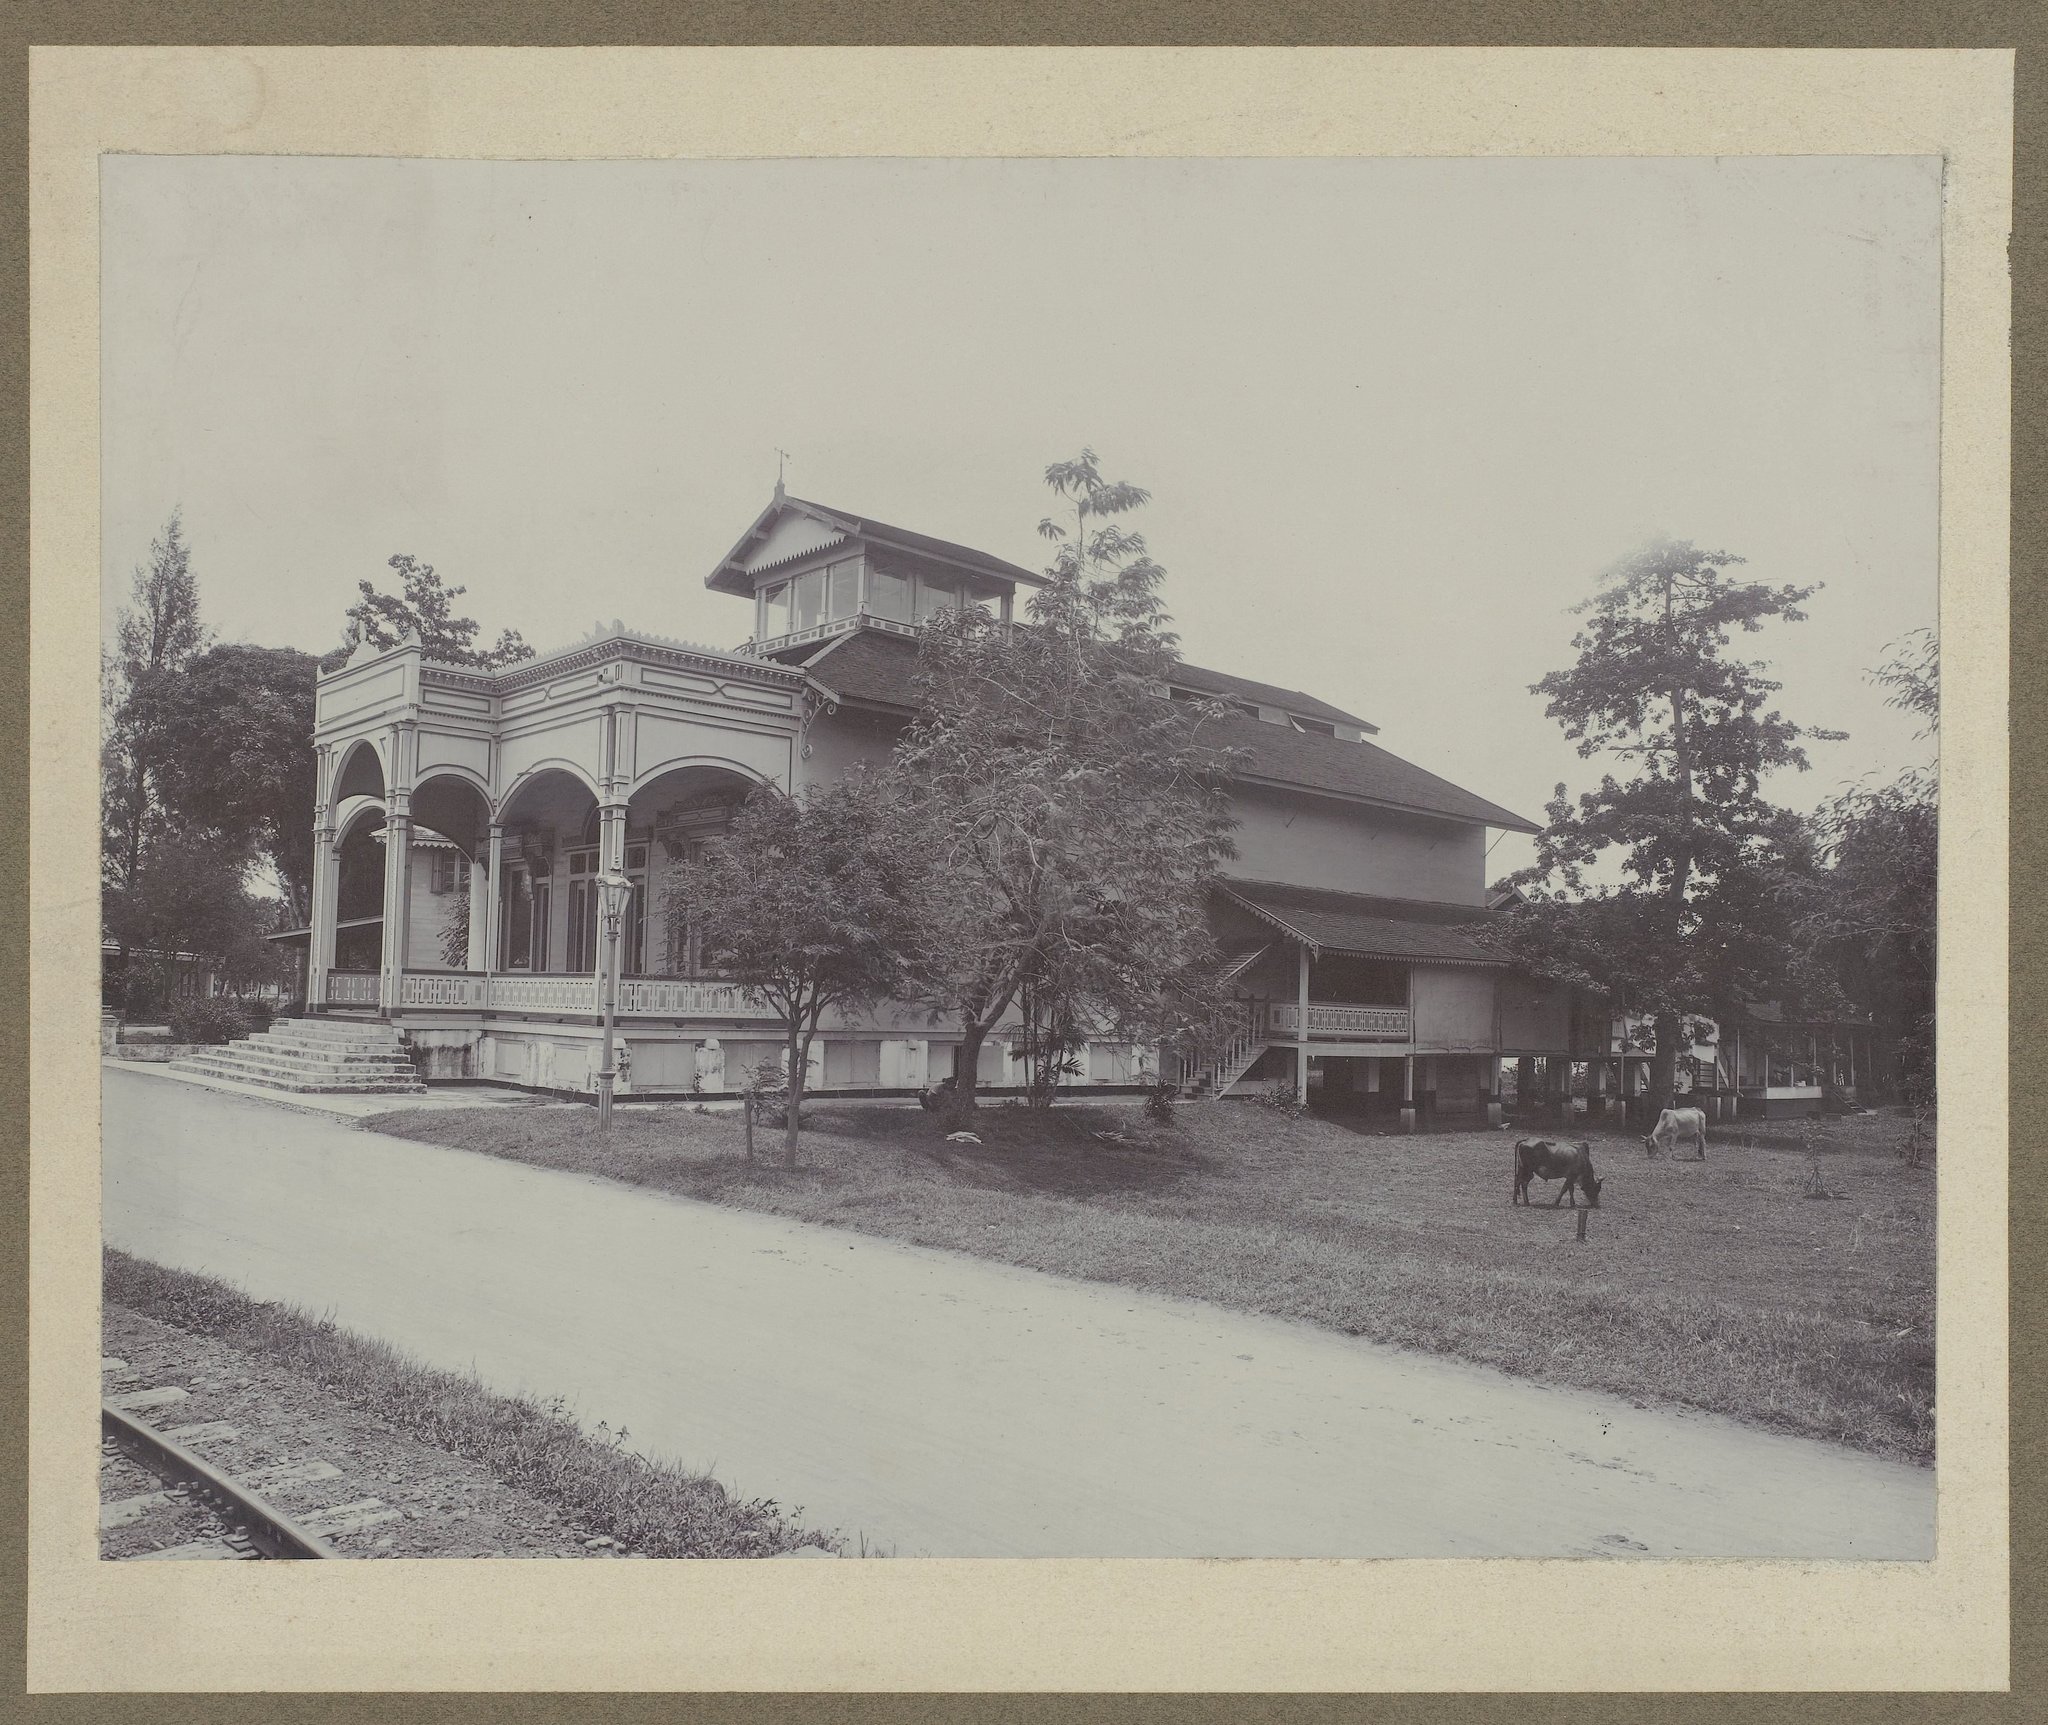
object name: photograph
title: Atjeh Drukkerij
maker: Anonymous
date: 1900-1914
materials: cardboard, photographic support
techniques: collodion silver print, gelatin silver print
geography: banda atjeh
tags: dutch east indies, the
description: Zijaanzicht van de Atjeh drukkerij te Banda Atjeh. Het gebouw voordat de naam van de drukkerij op de gevel is geschilderd, dus mogelijk kort voor of na overname, ca. 1900-1914. Naast het gebouw grazen koeien, voor het pand een weg en een spoor- of trambaan. Foto opgeplakt op karton. Onderdeel van een groep van negen foto's over de Atjeh-drukkerij.